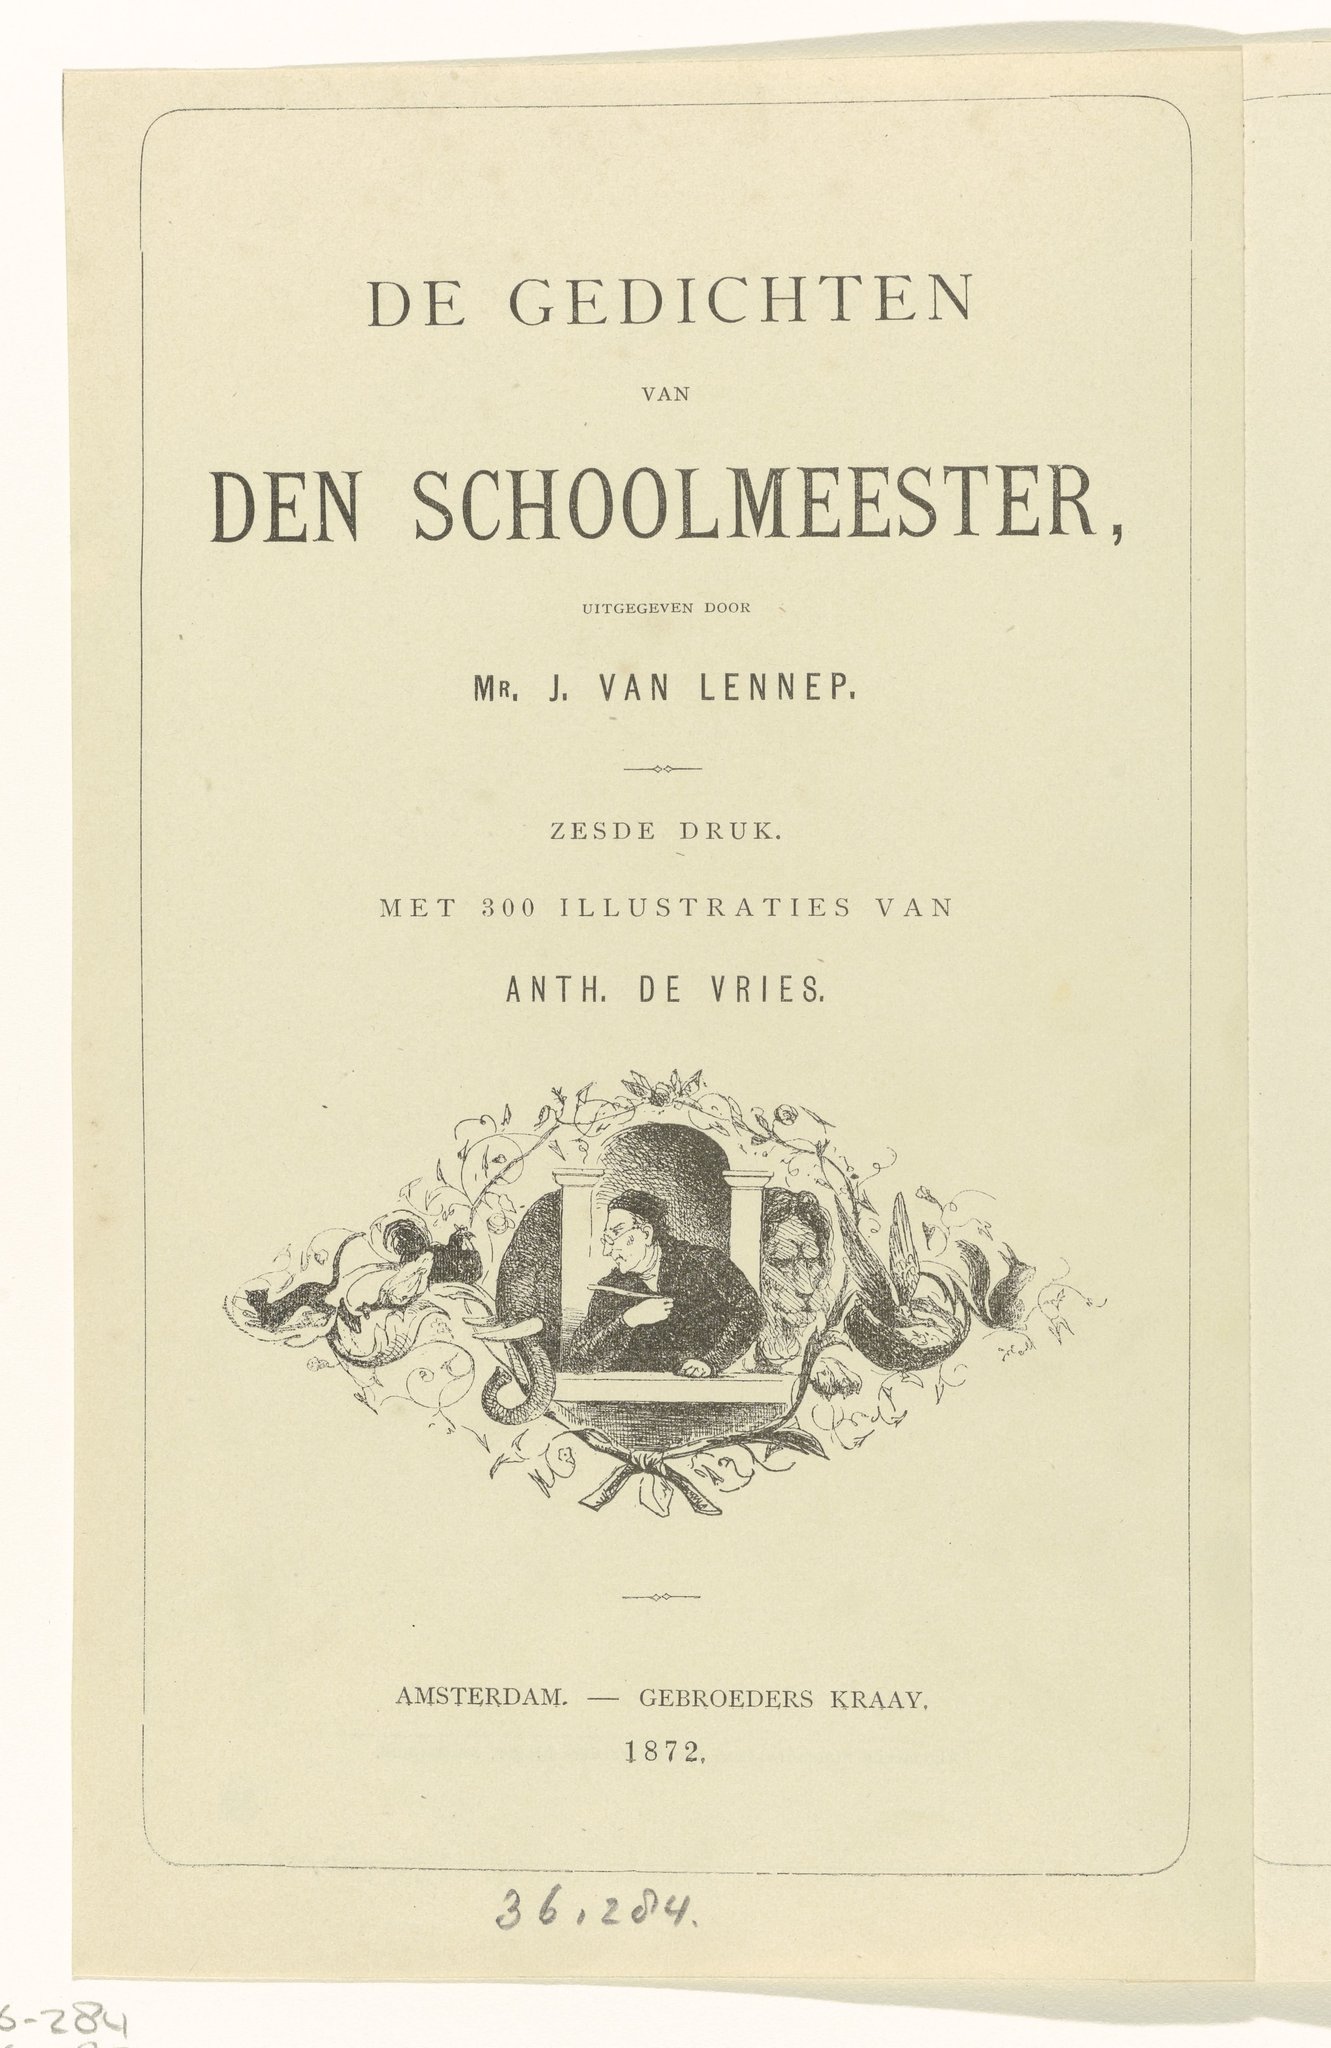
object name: print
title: Titelpagina voor: De Schoolmeester, De gedichten van den Schoolmeester, 1872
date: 1872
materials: paper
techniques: letterpress printing, engraving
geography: amsterdam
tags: cat, birds, teacher and pupil, beasts of prey, predatory animals: lion, trunked animals: elephant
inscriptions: collector's mark: Lugt 2760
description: Portret van een schoolmeester onder een toog. Daar omheen een aantal dieren, waaronder een kat, een olifant, een leeuw en verschillende vogels.